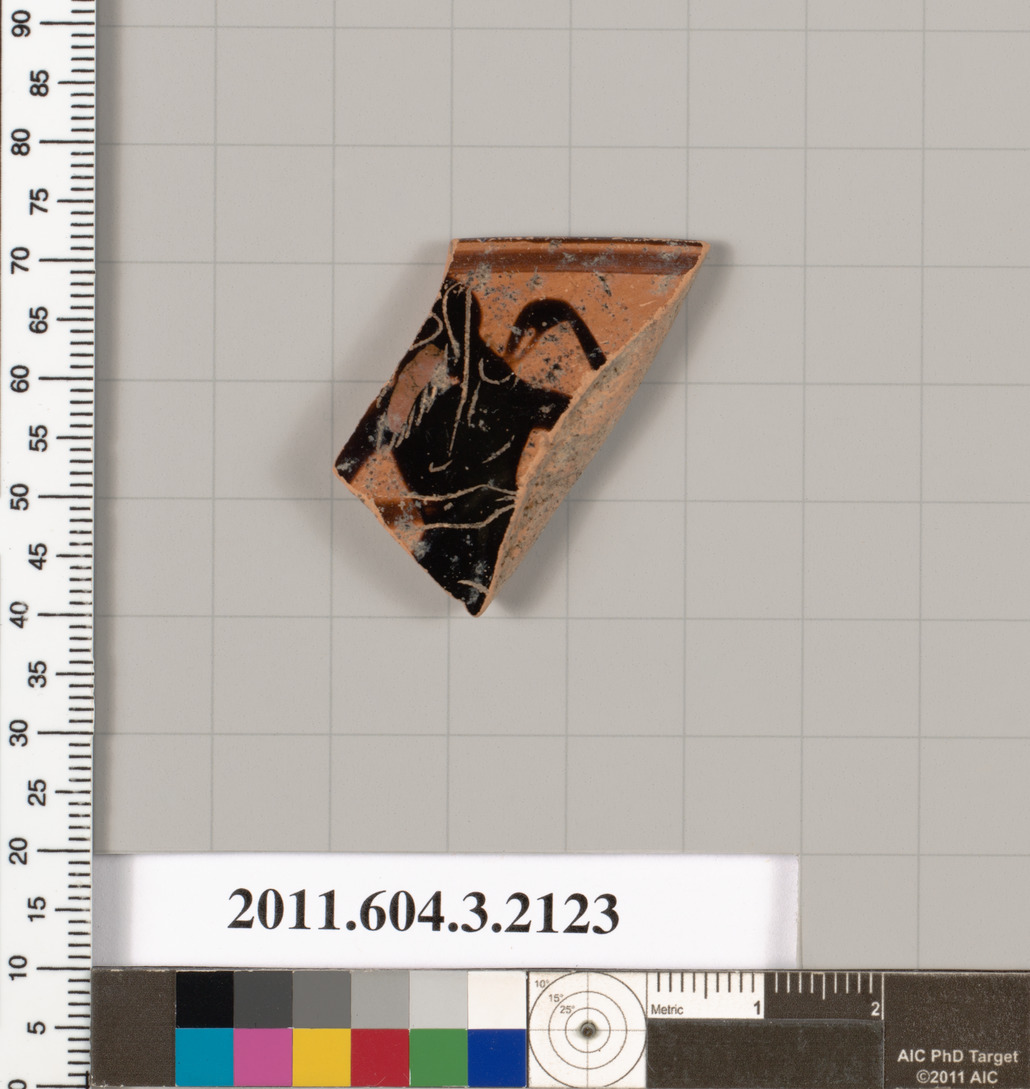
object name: kylix fragment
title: Terracotta rim fragment of a kylix (drinking cup)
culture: greek, attic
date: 534-468 BCE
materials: terracotta